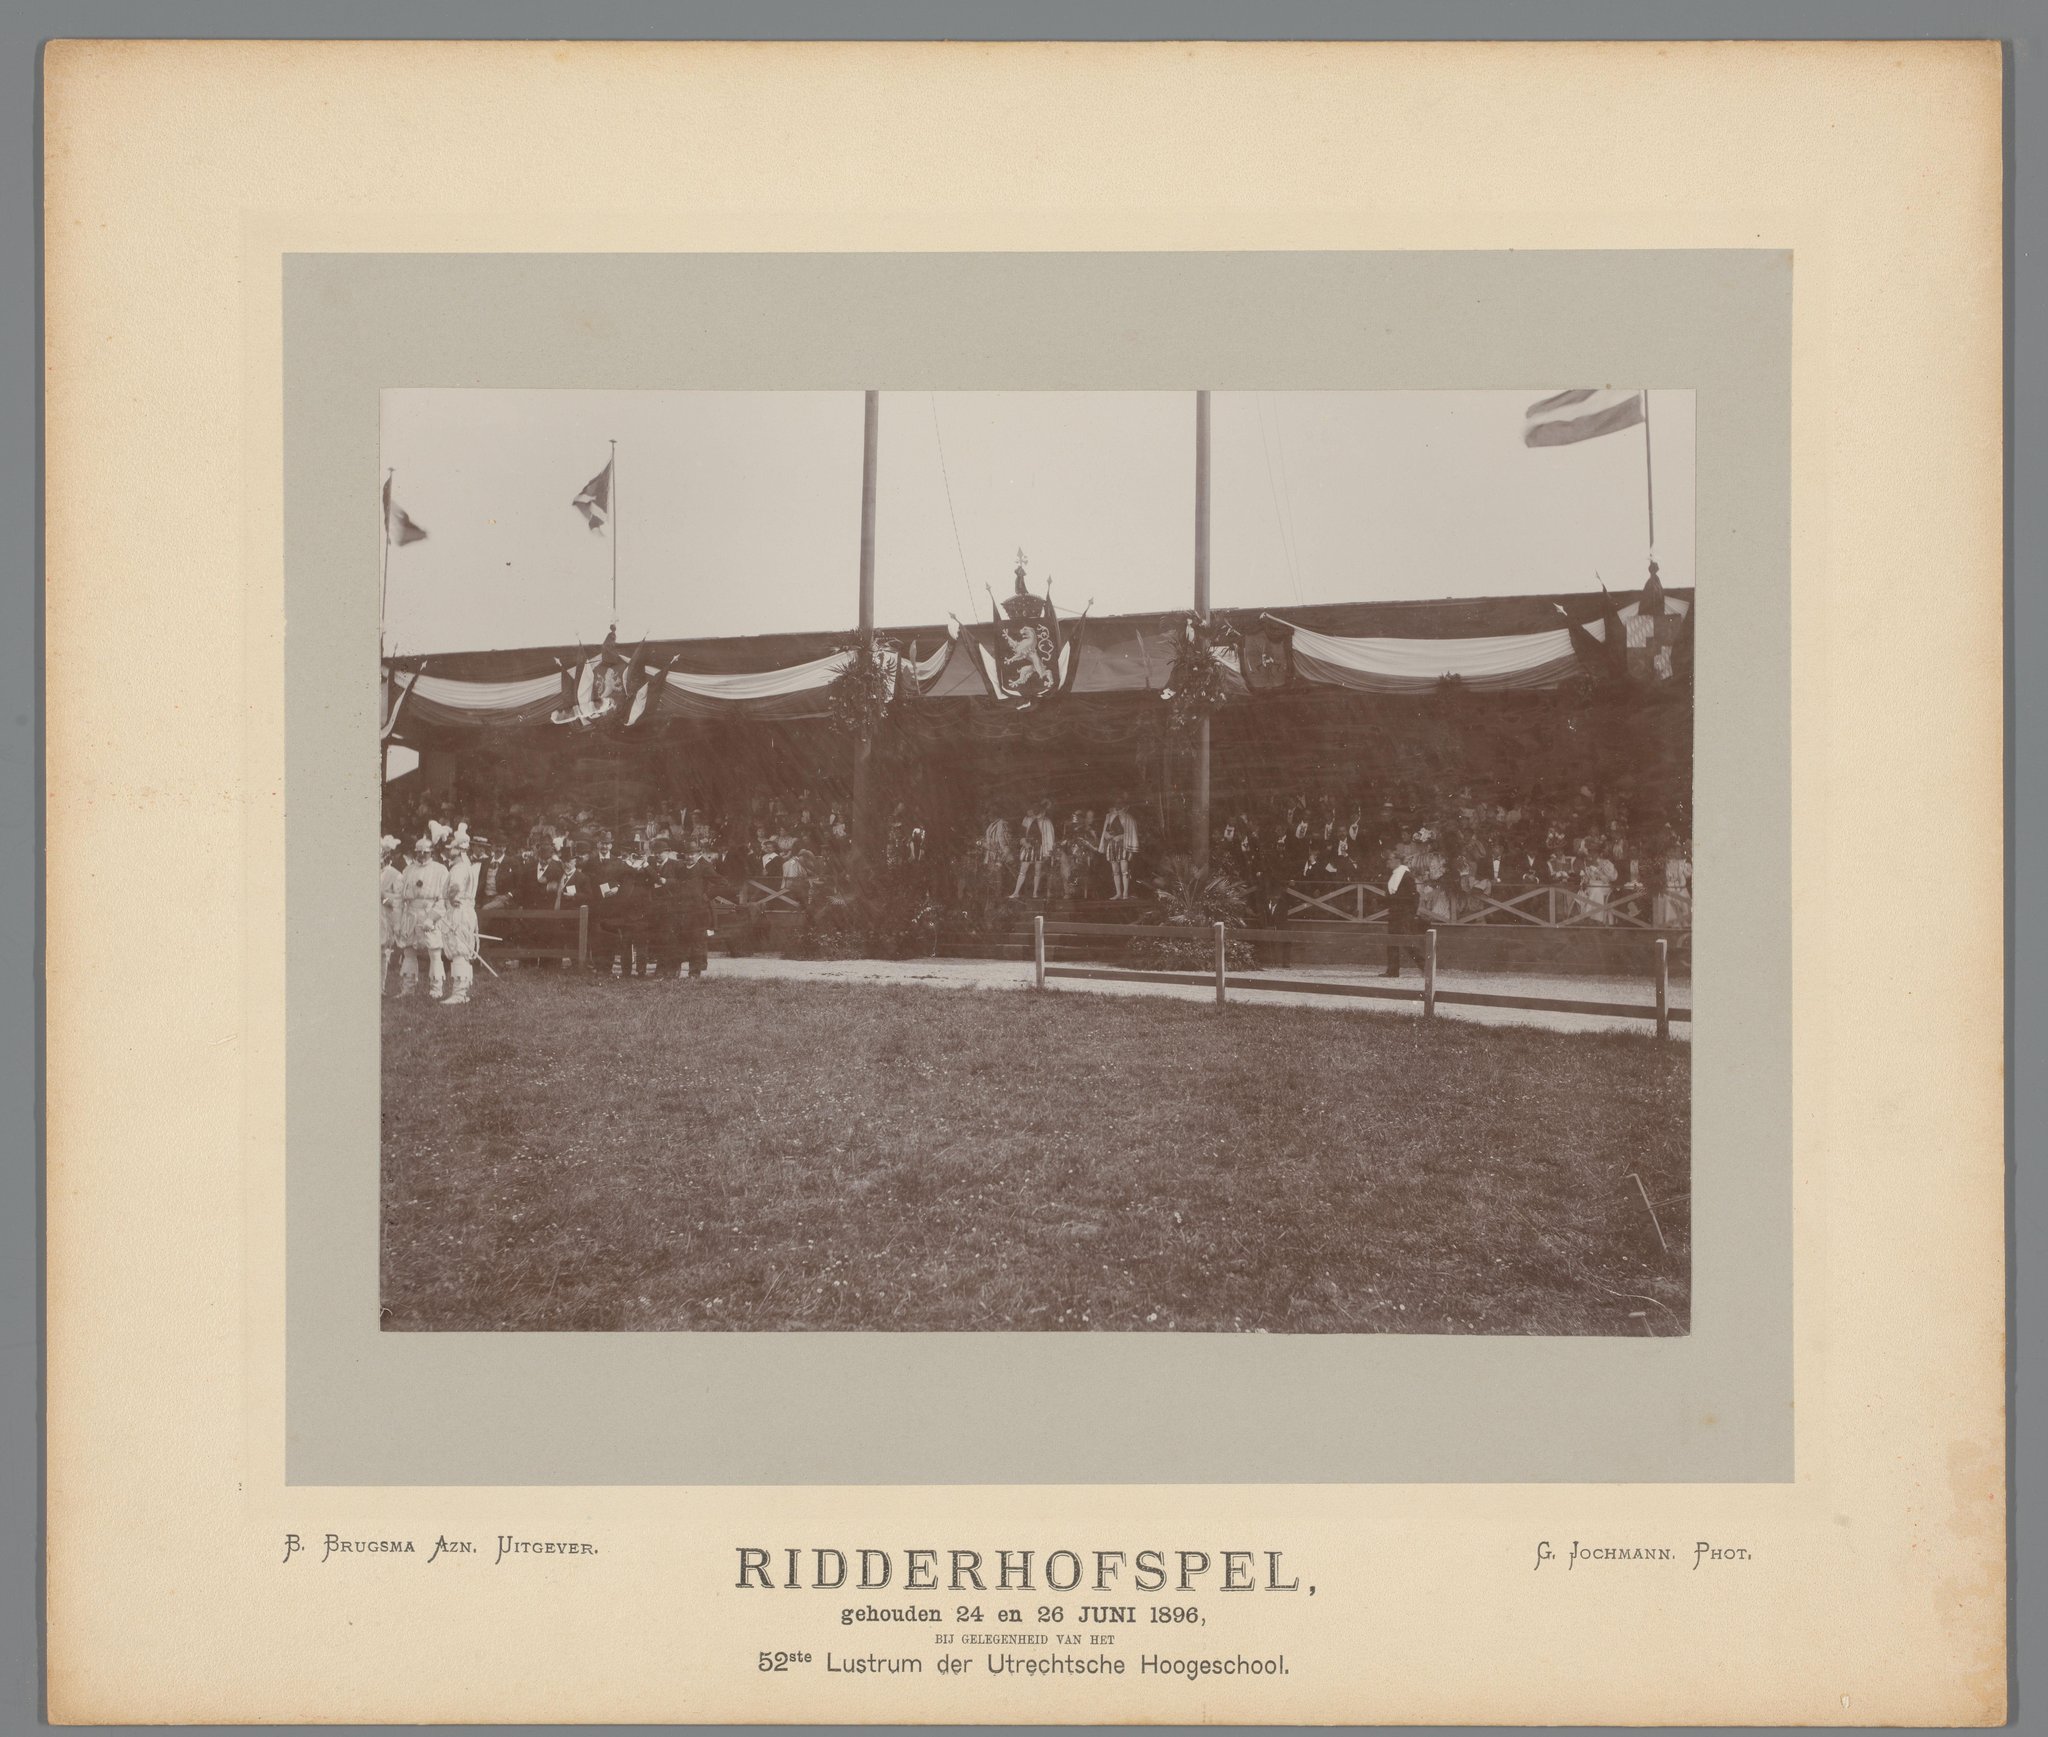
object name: photograph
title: Ridder in harnas op een troon tussen het publiek tijdens de Ridderhofspelen op 24 en 26 juni 1896 in Utrecht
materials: cardboard, paper, photographic support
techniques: collodion silver print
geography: utrecht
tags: (medieval) fighting contest, public festivities, knight, utrecht